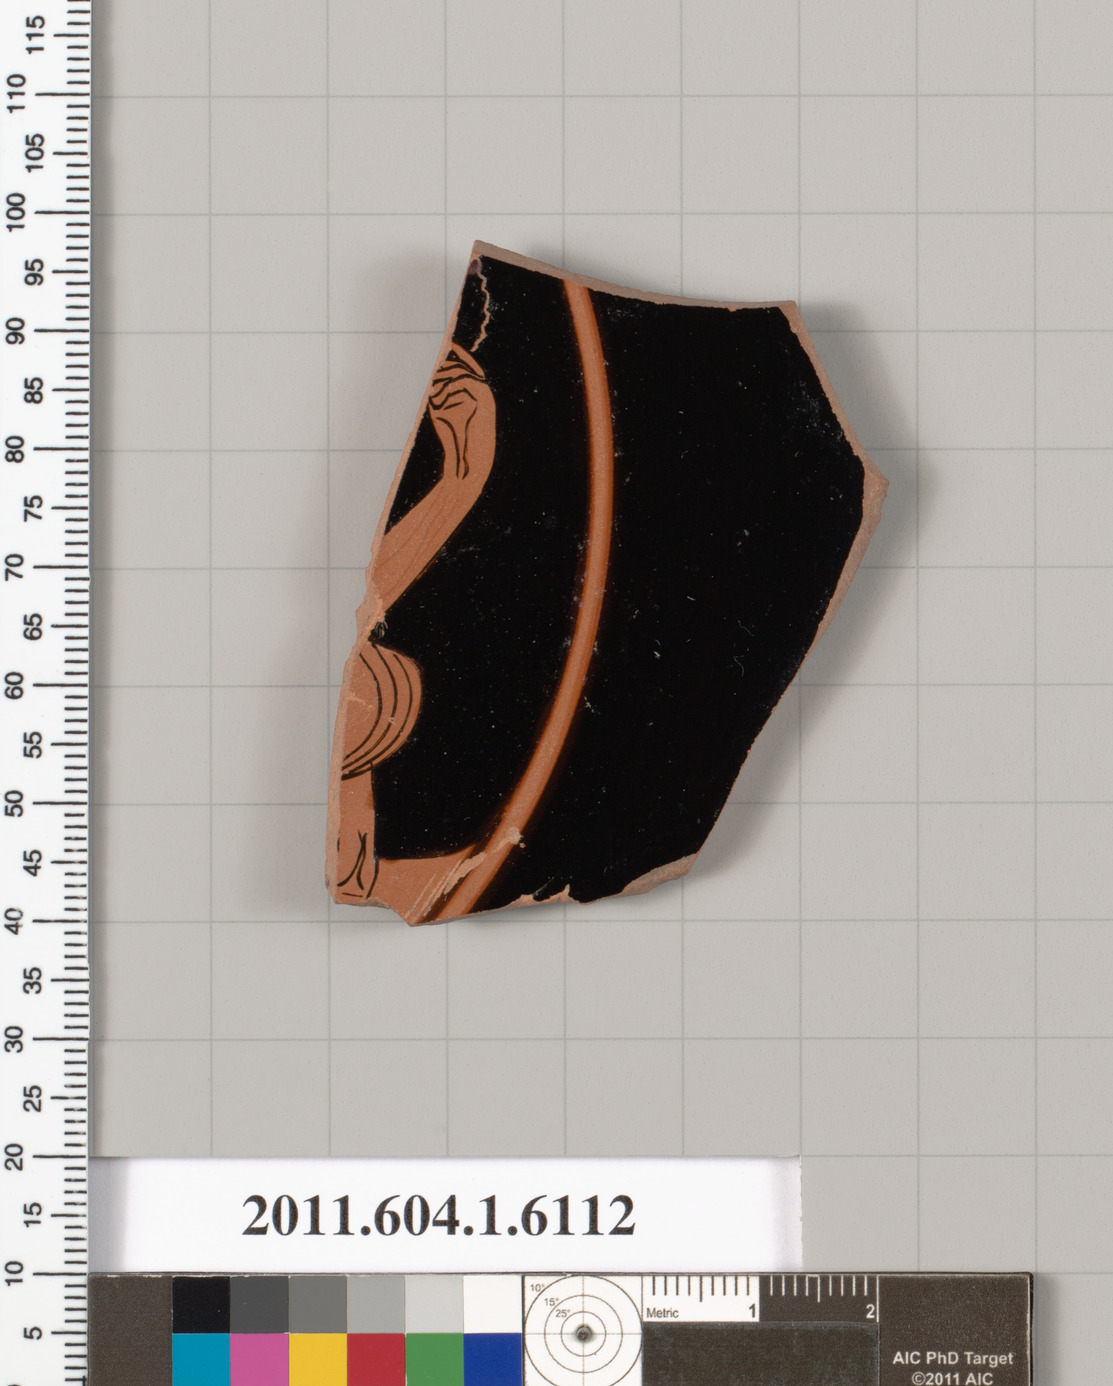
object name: kylix fragment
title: Terracotta fragment of a kylix (drinking cup)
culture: greek, attic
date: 510-490 BCE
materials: terracotta